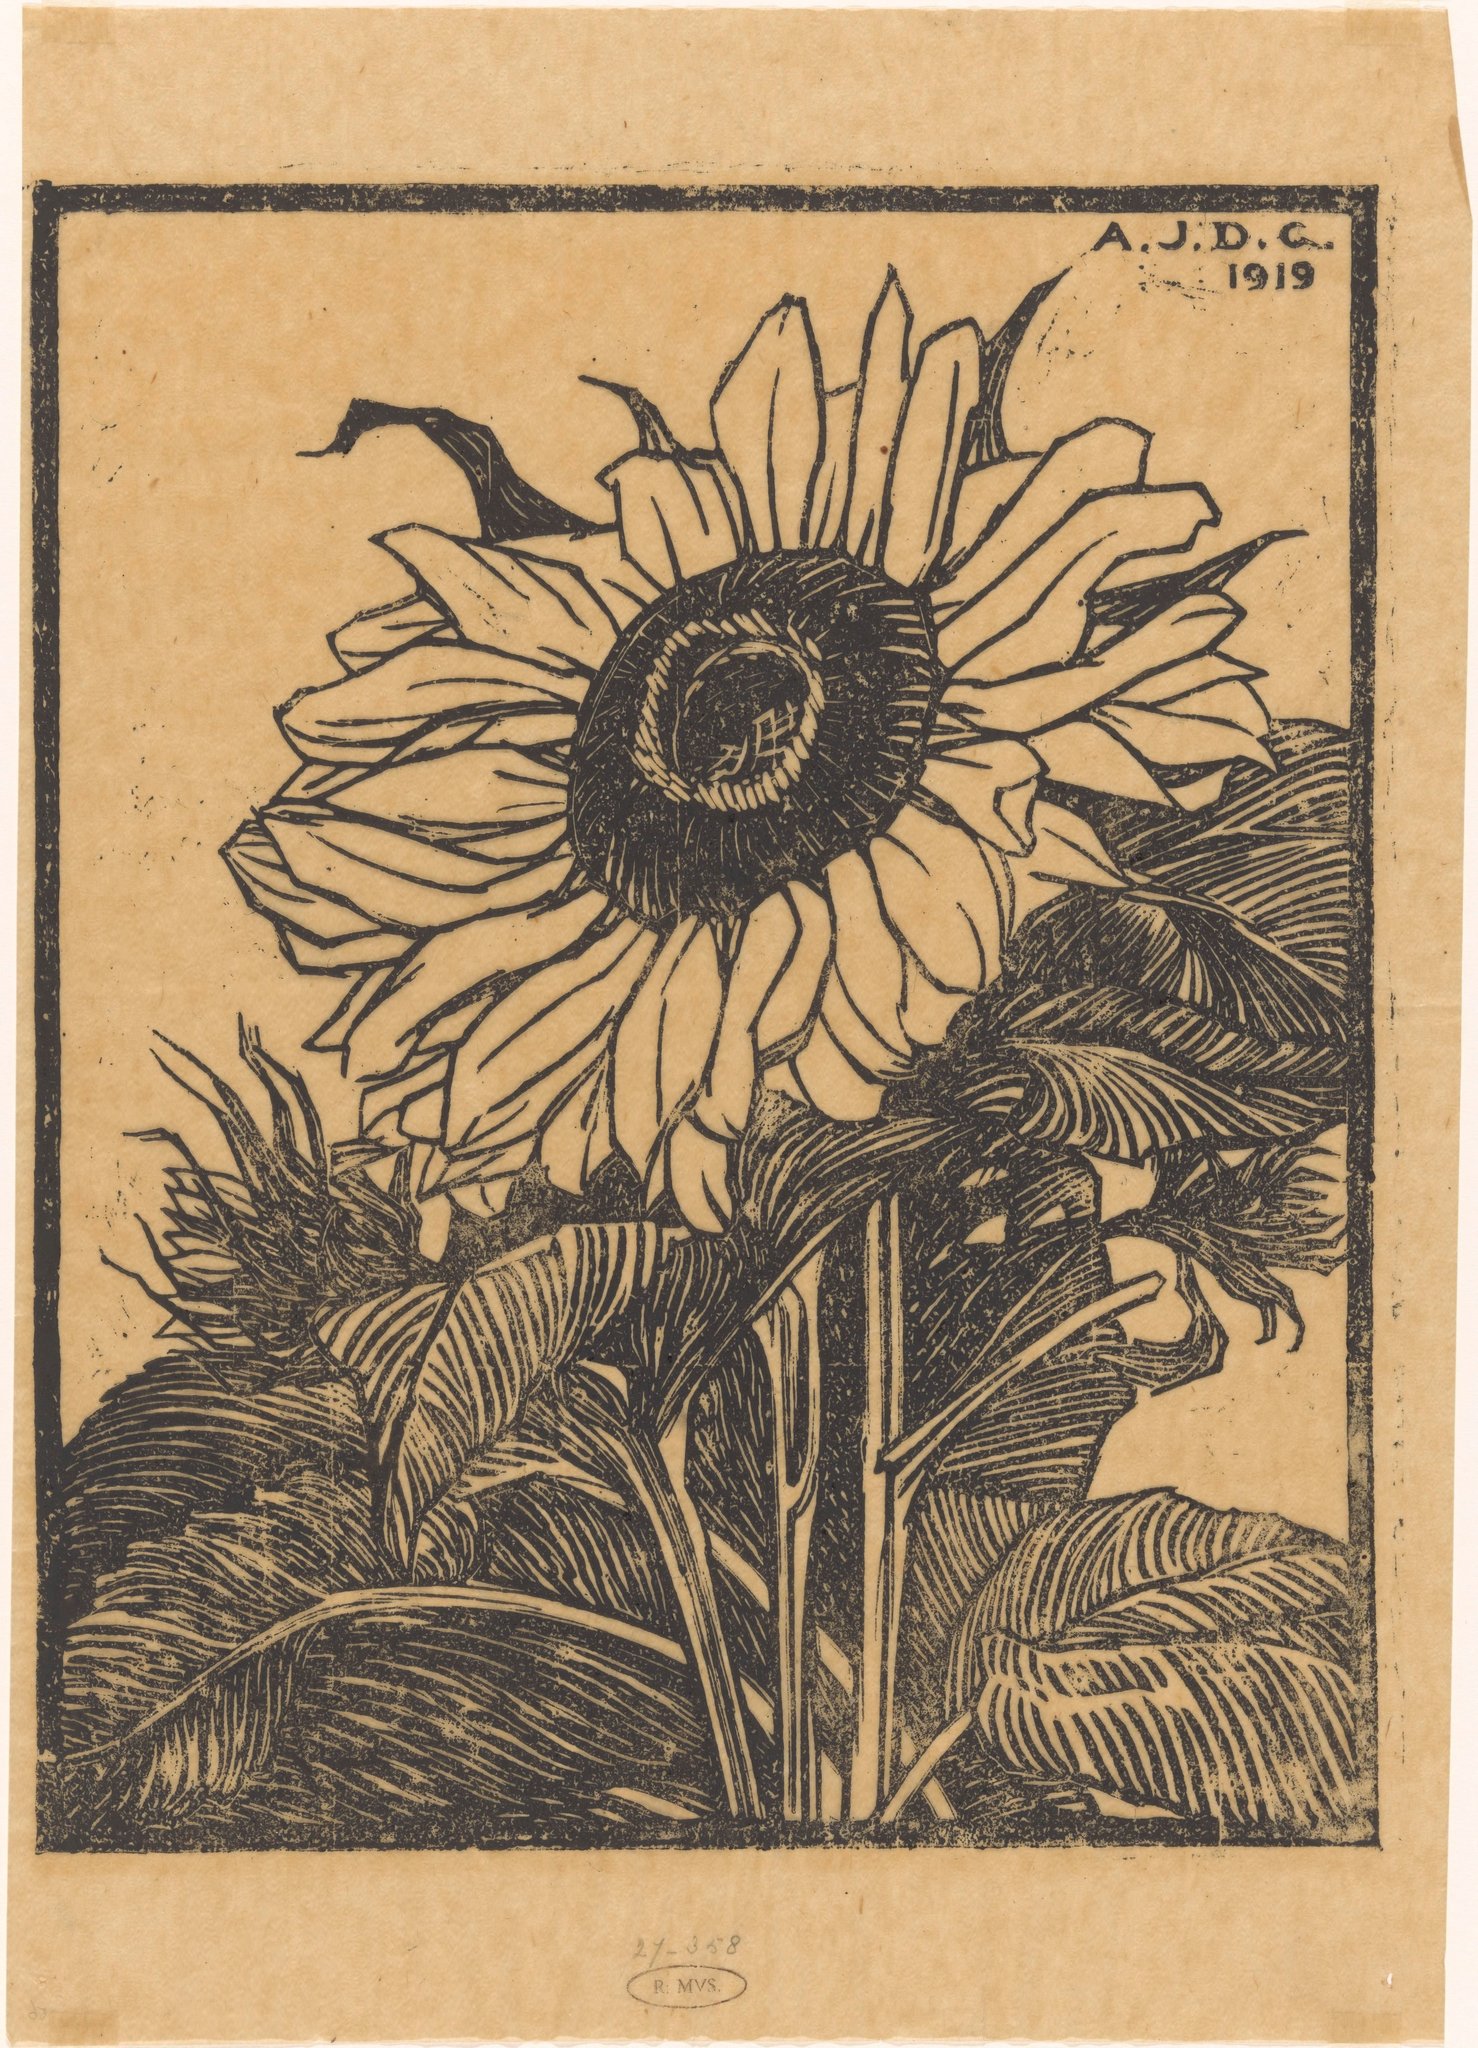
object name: print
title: Zonnebloem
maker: julie de graag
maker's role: draughtsman, print maker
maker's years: 1877-1924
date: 1919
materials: paper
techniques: woodcut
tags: flowers: sunflower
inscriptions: collector's mark: Lugt 2228